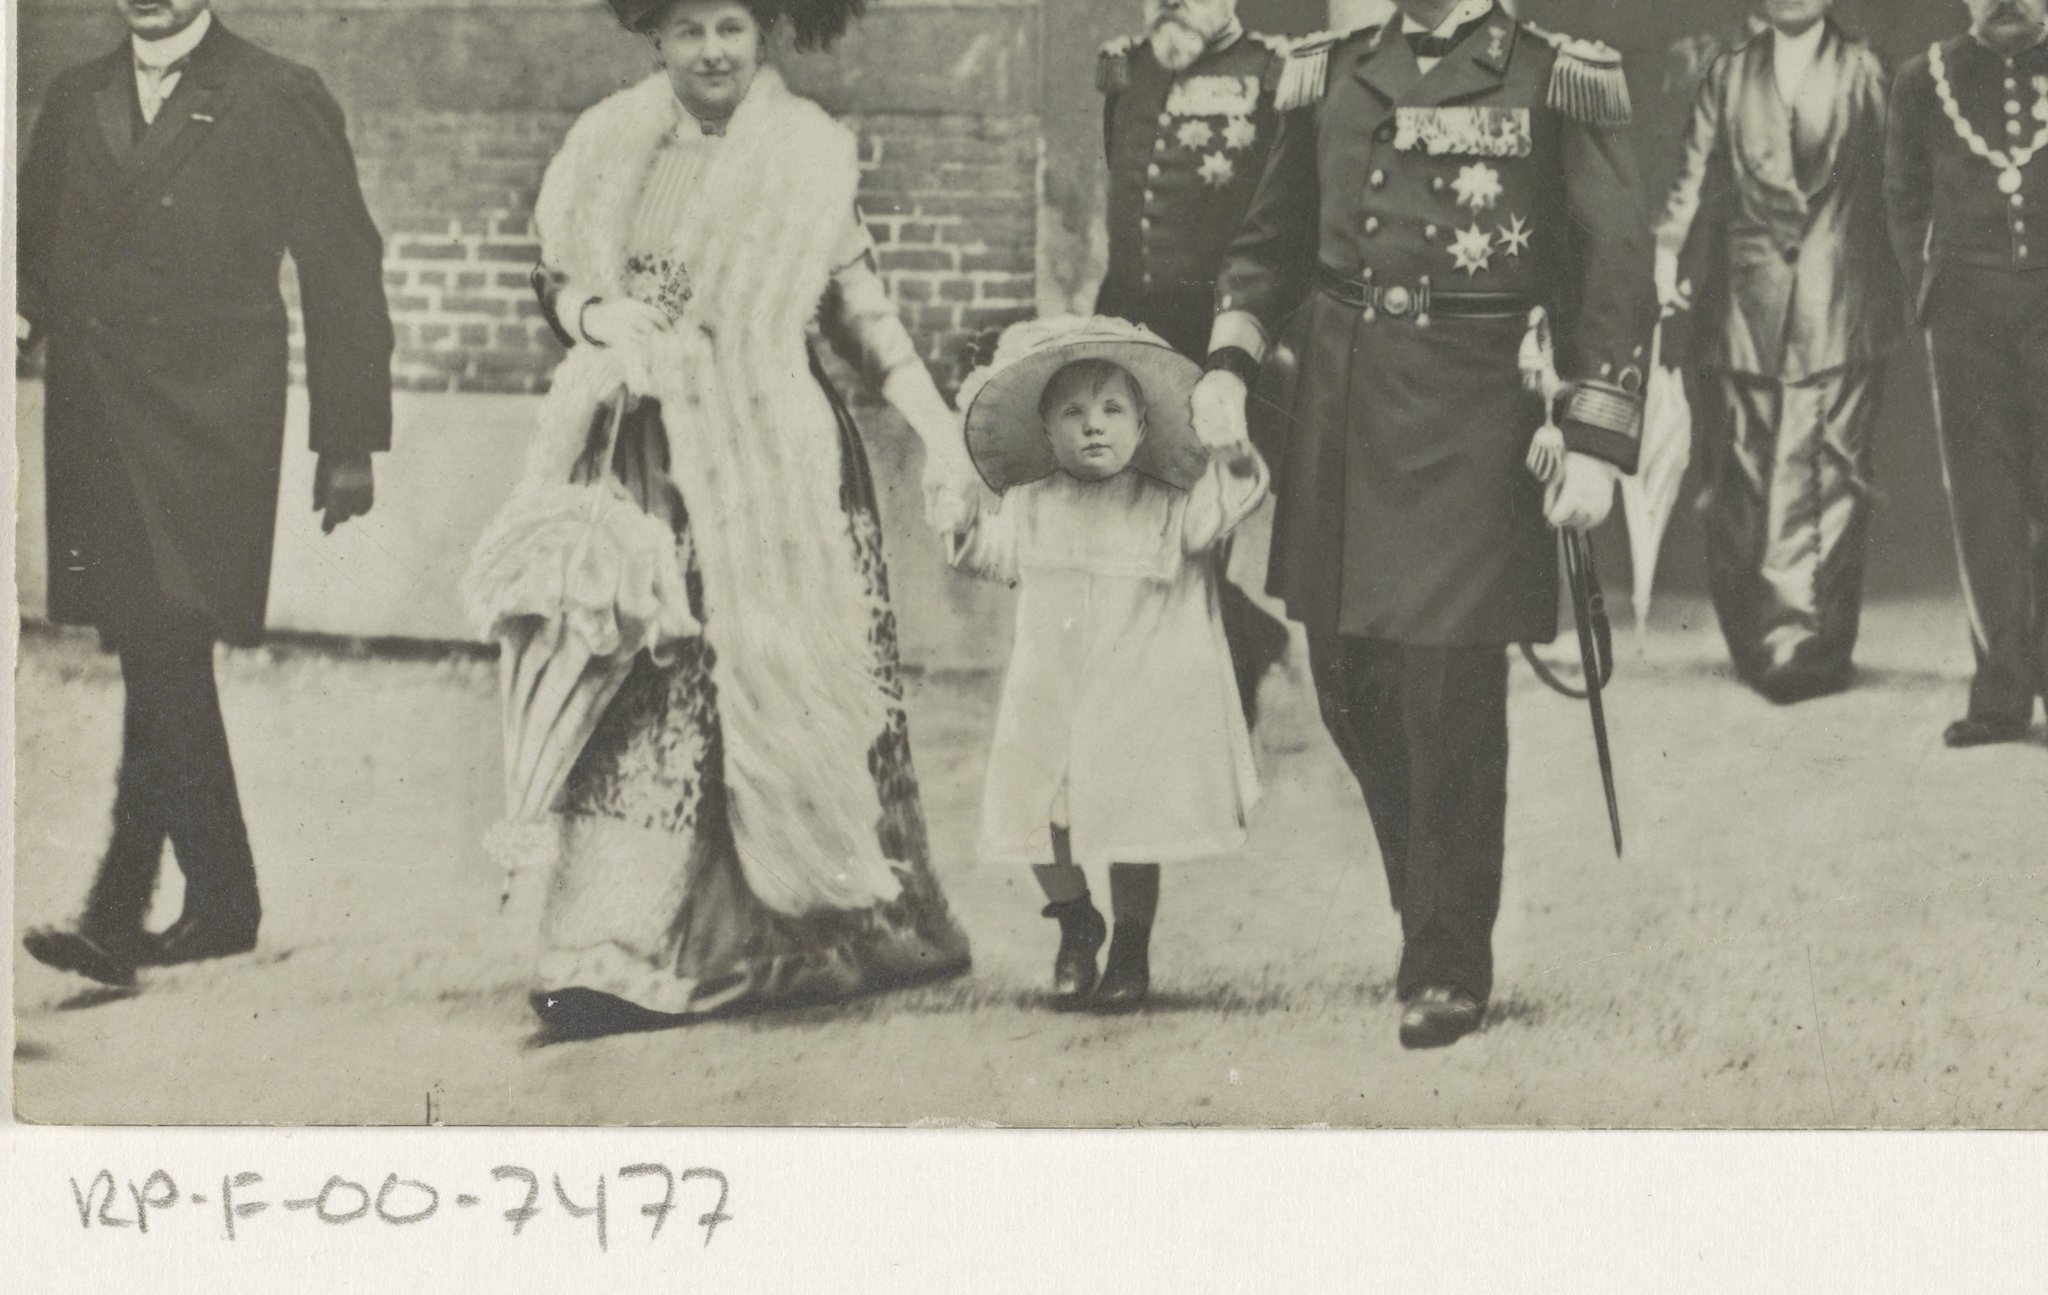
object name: ansichtkaart, prentbriefkaart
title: Portret van Wilhelmina, koningin der Nederlanden, Hendrik van Mecklenburg-Schwerin en Juliana, koningin der Nederlanden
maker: Anonymous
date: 1911-1914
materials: photographic support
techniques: photography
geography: netherlands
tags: the hague, print maker, wilhelmina of the netherlands, hendrik (prins der nederlanden (1876-1934)), juliana of the netherlands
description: De hier vermelde titel verwijst naar de hoogst verkregen titel van de geportretteerde, niet per se naar de titel die de geportretteerde op deze voorstelling draagt.